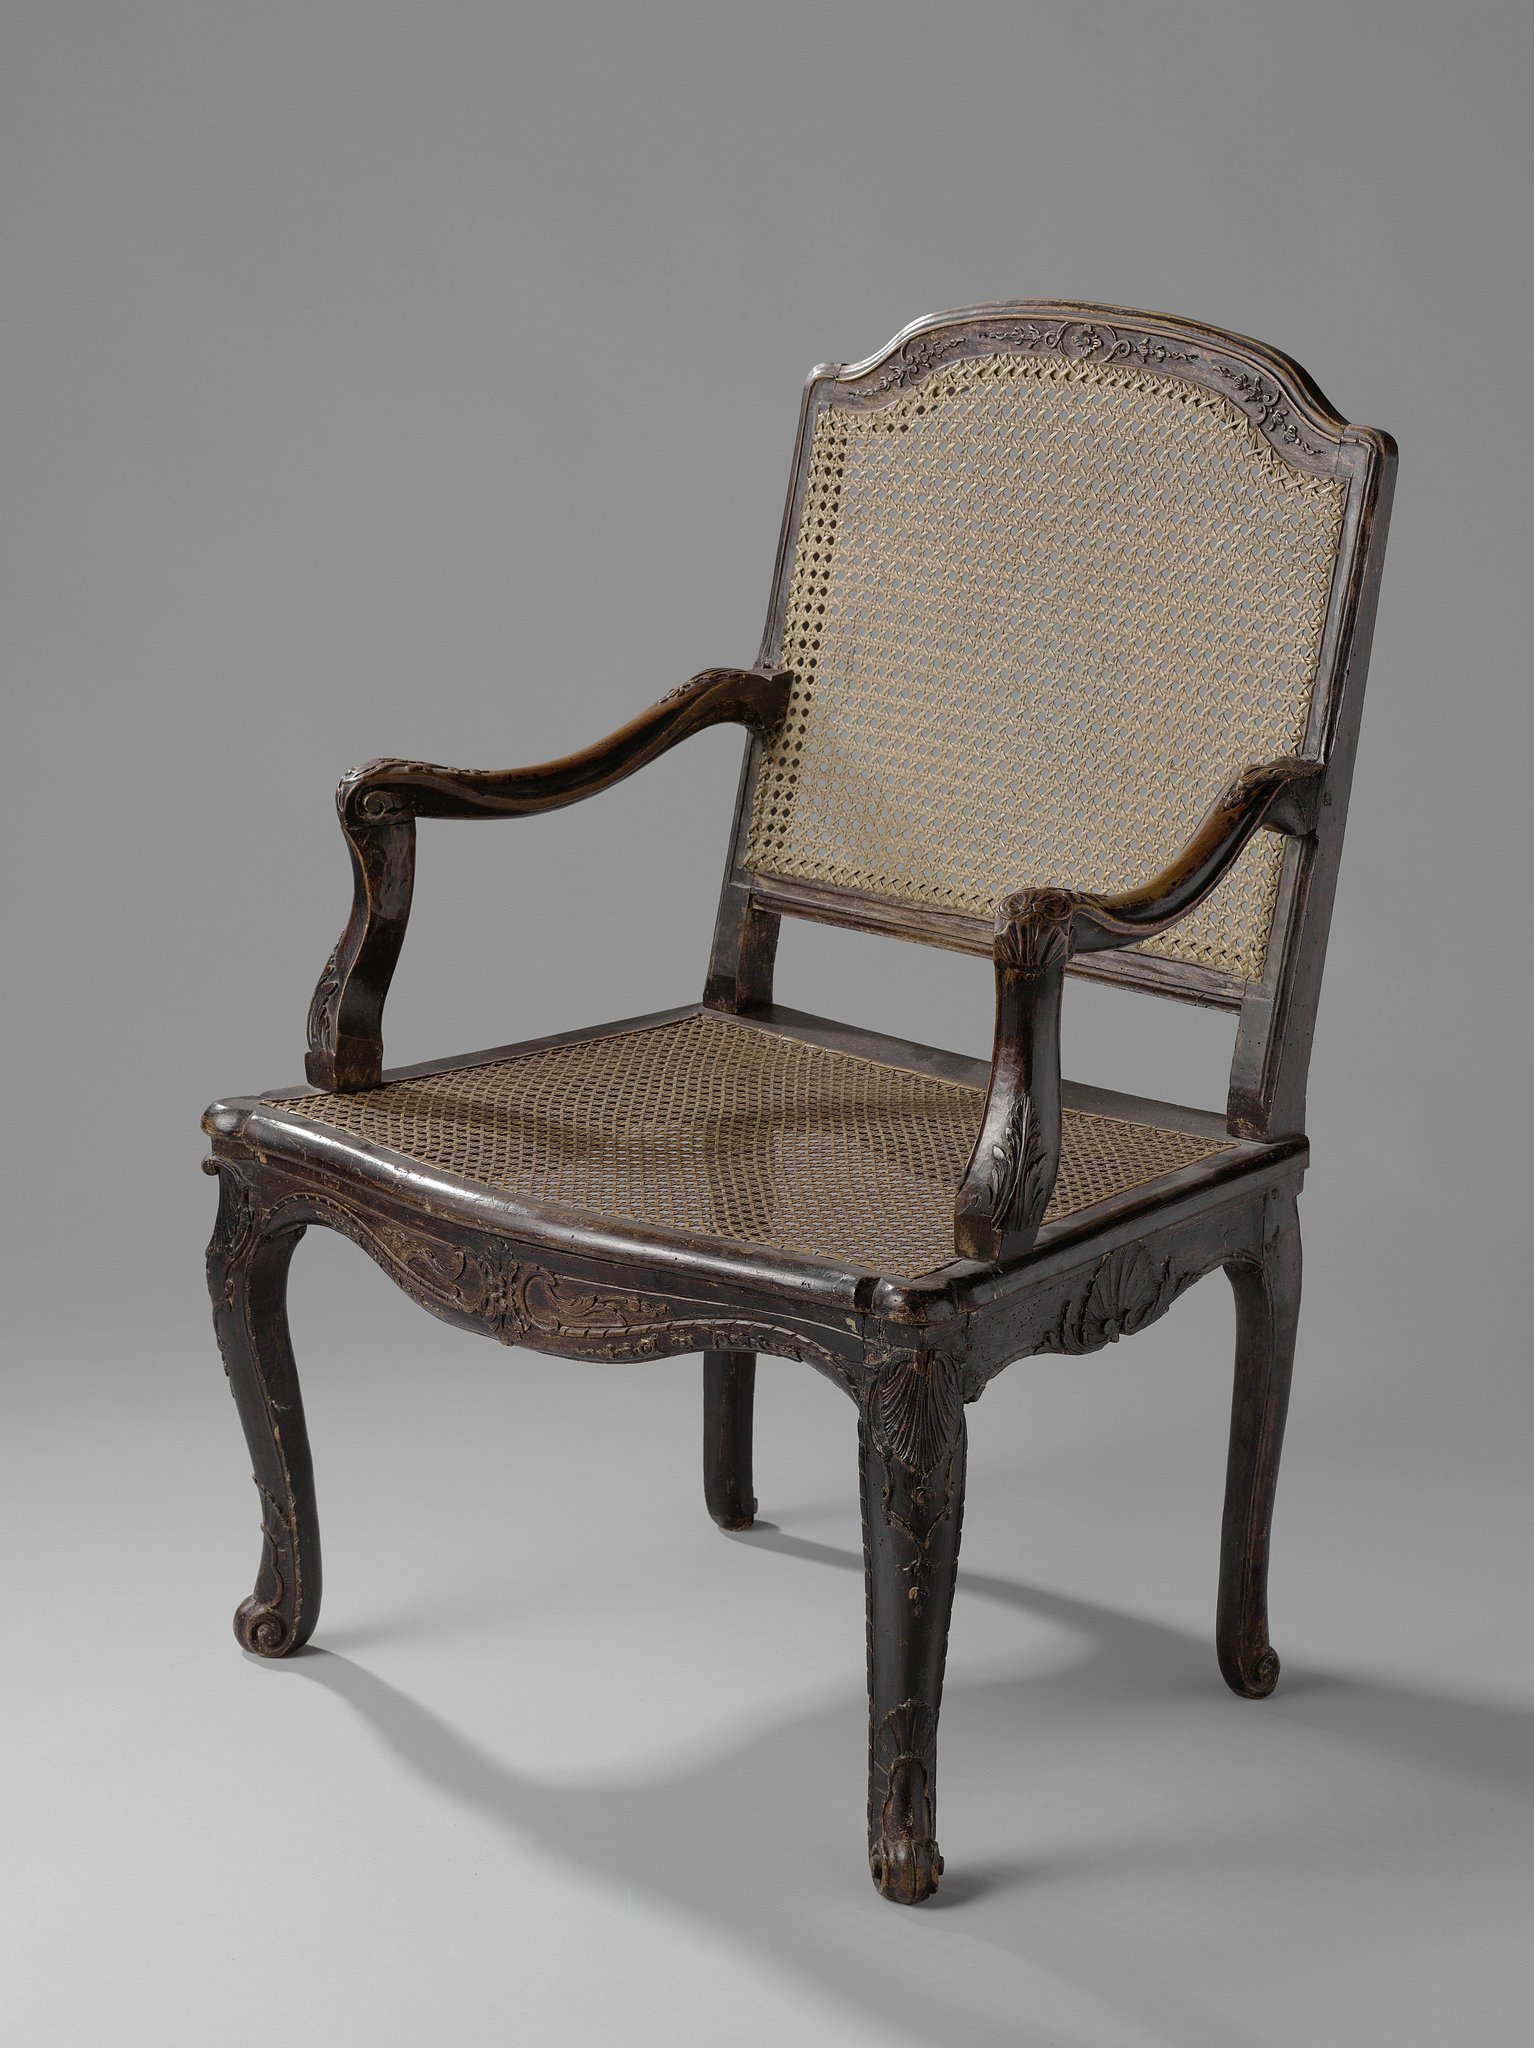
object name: chair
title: Armstoel van lichtbruin gelakt beukenhout met overhoeks geplaatste S-vormige poten, zitting en rug van gevlochten riet, zitregels, voorpoten en bovendorpel met bladornament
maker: Anonymous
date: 1730-1750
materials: wood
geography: france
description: Armstoel van lichtbruin gelakt beukenhout, rustend op overhoeks geplaatste S-vormige poten. Het trapeziumvormige zitraam en de rug, van boven gebogen, zijn van gevlochten riet. De geholde armleggers wijken buitenwaarts, eindigen in voluten en rusten op achterwaarts geplaatste S-vormige stutten. De armleggers, armleggerstutten, geschulpte zitregels, de voorpoten en de bovendorpel van de rug zijn versierd met een gesneden bladornament.